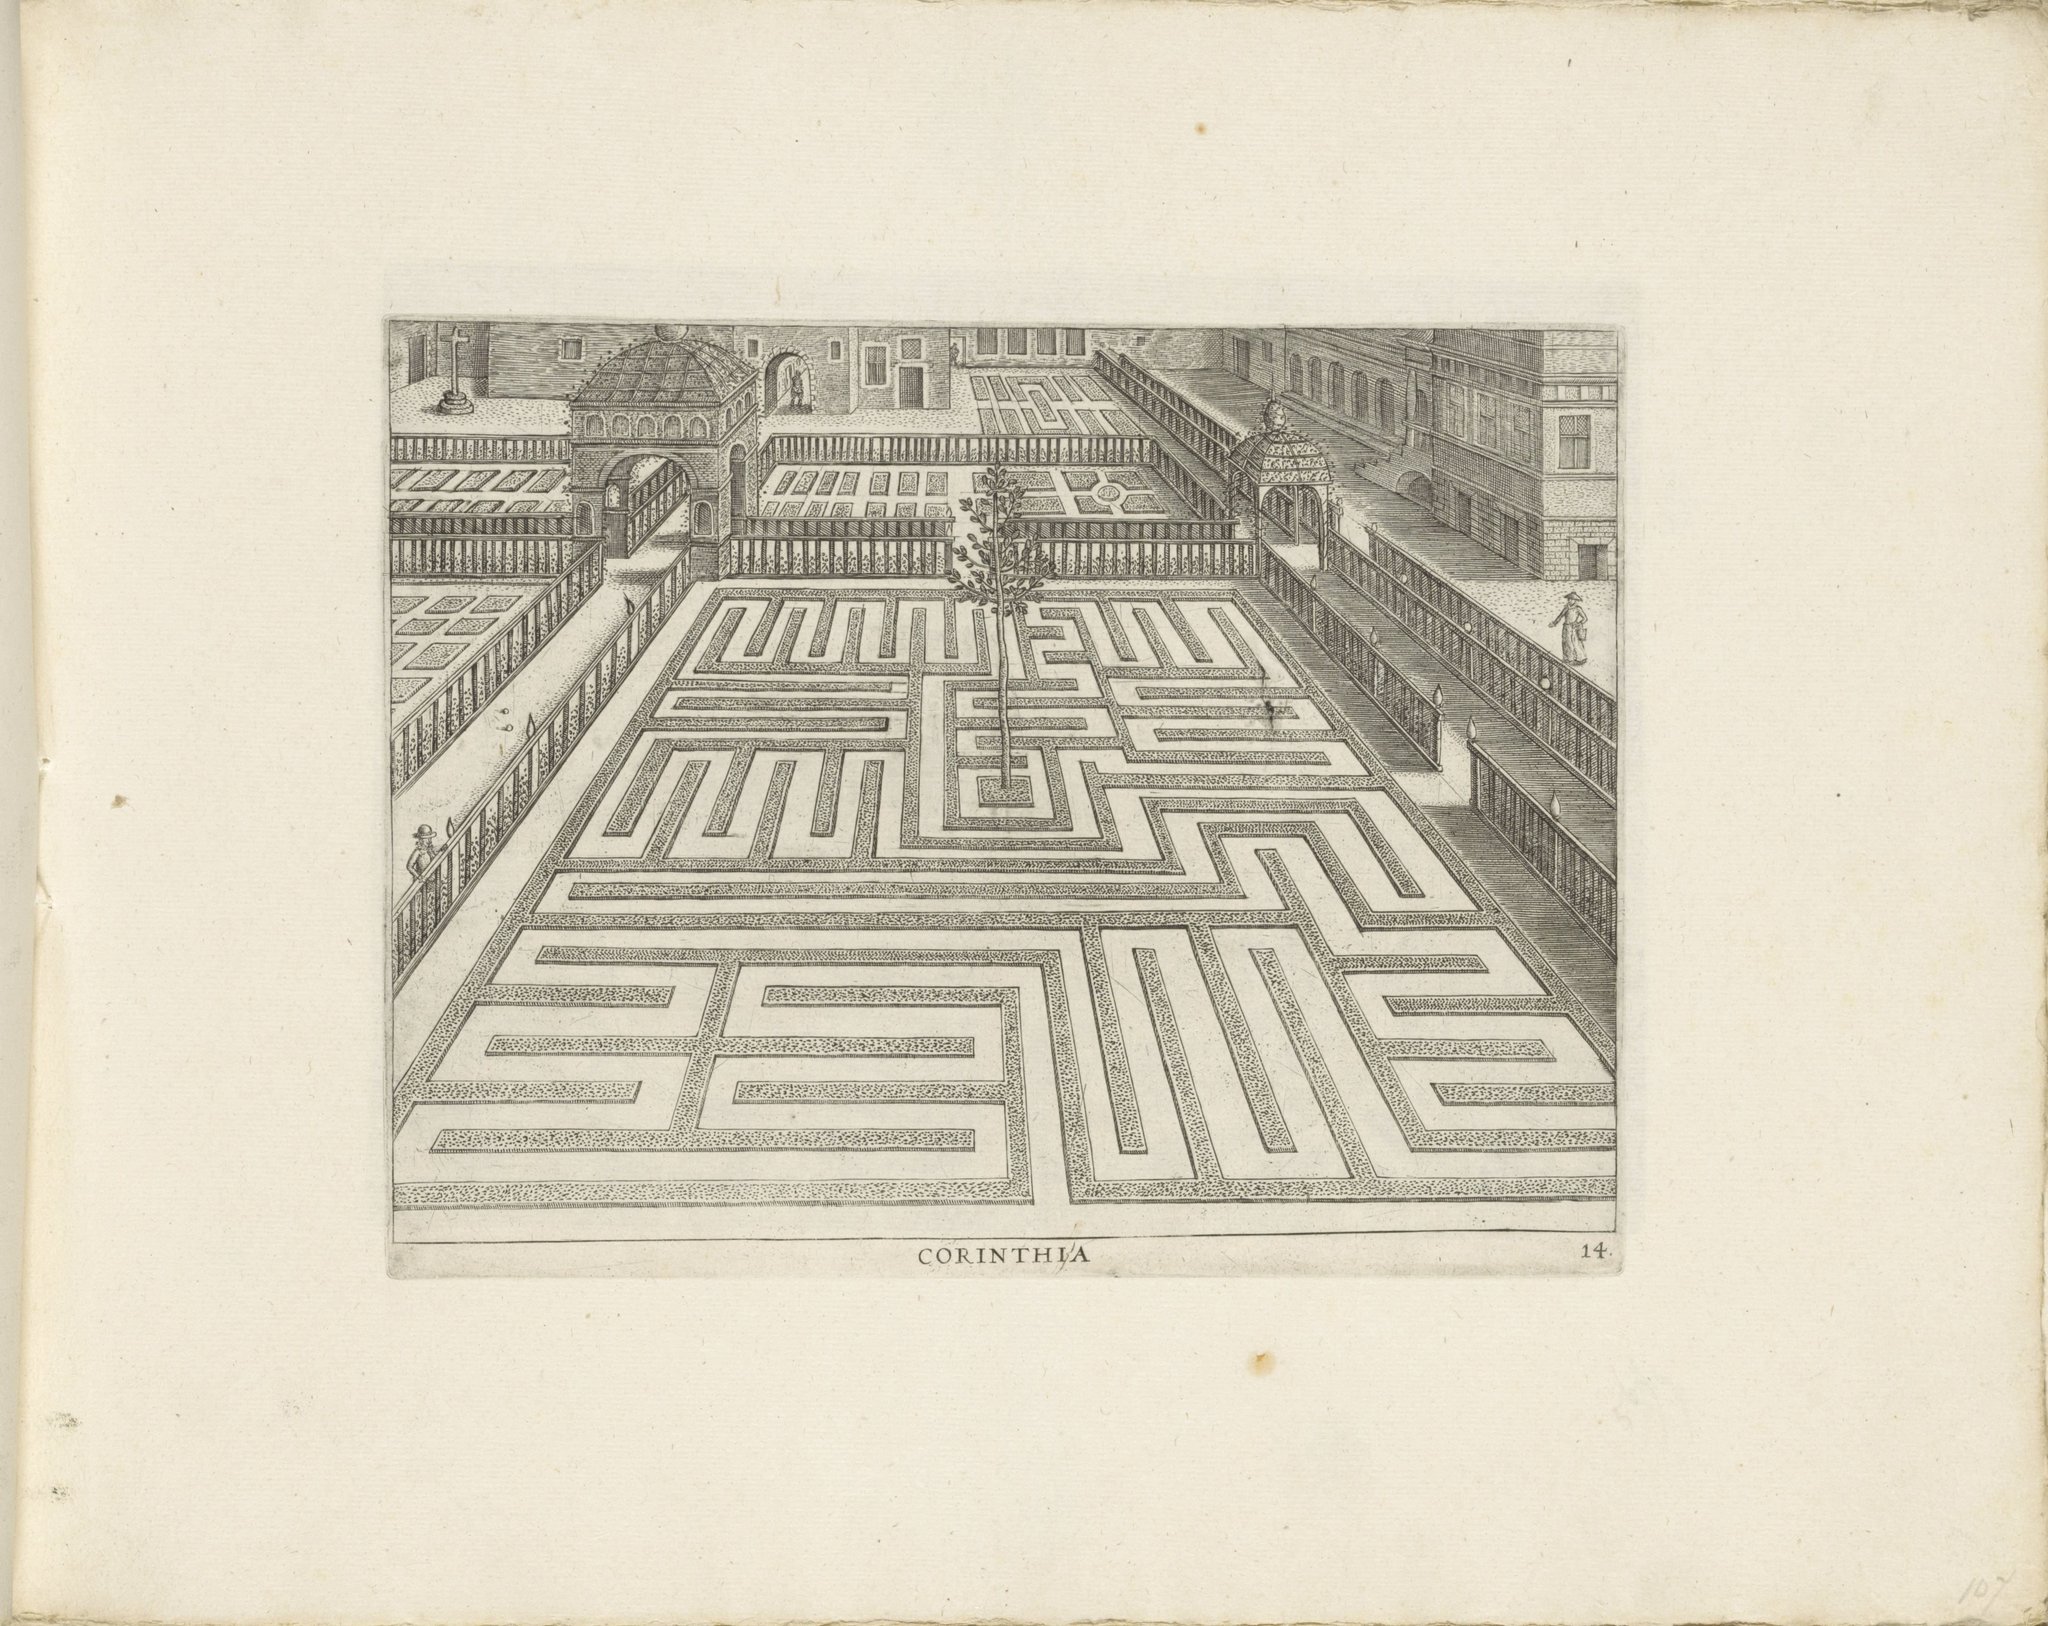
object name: print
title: Tuin met een rechthoekig parterre en een boom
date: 1583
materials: paper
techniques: etching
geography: antwerp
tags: garden, french or architectonic garden; formal garden, labyrinth, maze ~ garden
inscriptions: collector's mark: Lugt 2760, collector's mark: Lugt 2228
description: De serie ‘Hortorum Viridariorumque’ van Vredeman de Vries (Hollstein Dutch 470-490) is in deze editie van de serie door uitgever Joannes Galle ( en eerder door zijn voorganger Theodoor Galle) aangevuld met de serie ‘Tuinen’ van Vredeman de Vries (Hollstein Dutch 508-515) en met twee prenten van Pieter van der Borcht (I) (New Hollstein Dutch 161-162). De prenten zijn genummerd: 1-30. Origineel hoort bij deze editie van de serie, uitgegeven door Joannes Galle, nog een prent van Van der Borcht met nummer 31, maar deze prent ontbreekt in deze serie in de collectie van het Rijksmuseum.